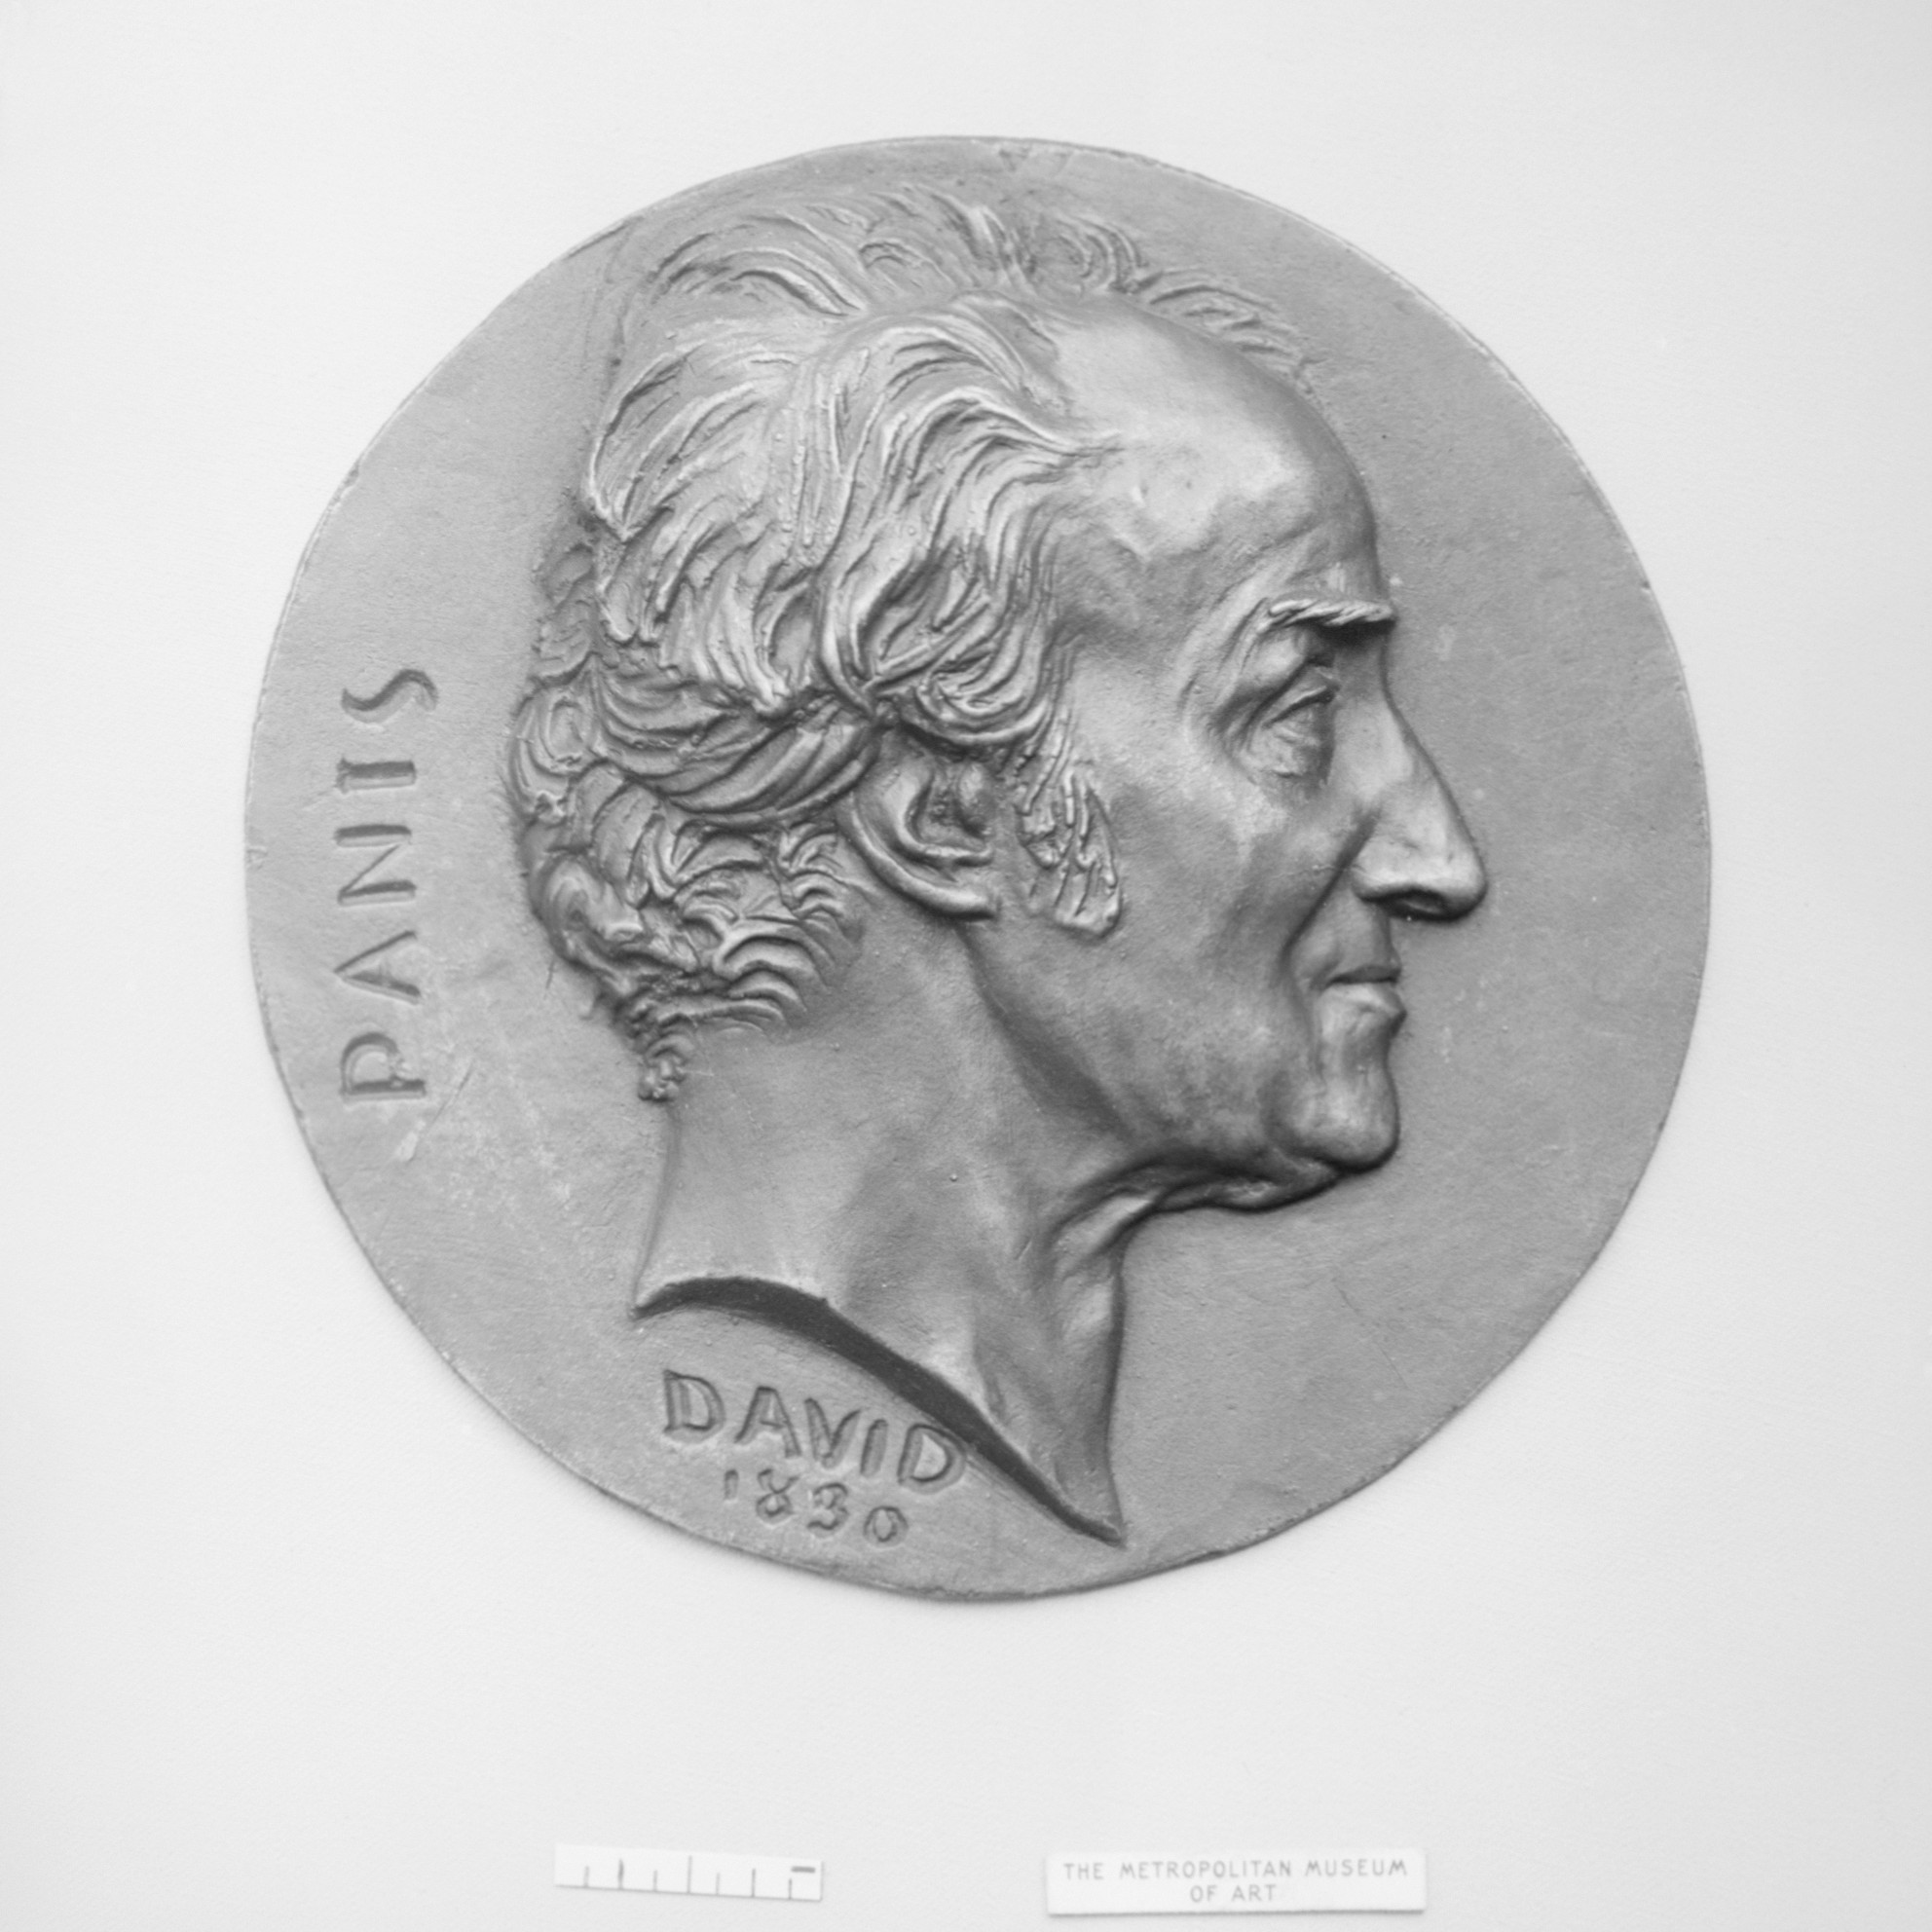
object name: medallion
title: Etienne Jean Panis, (1757–1832) French politician, member of the Convention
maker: pierre jean david d'angers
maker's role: artist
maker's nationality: french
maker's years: 1788-1856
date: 1830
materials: bronze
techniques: casting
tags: men,profiles